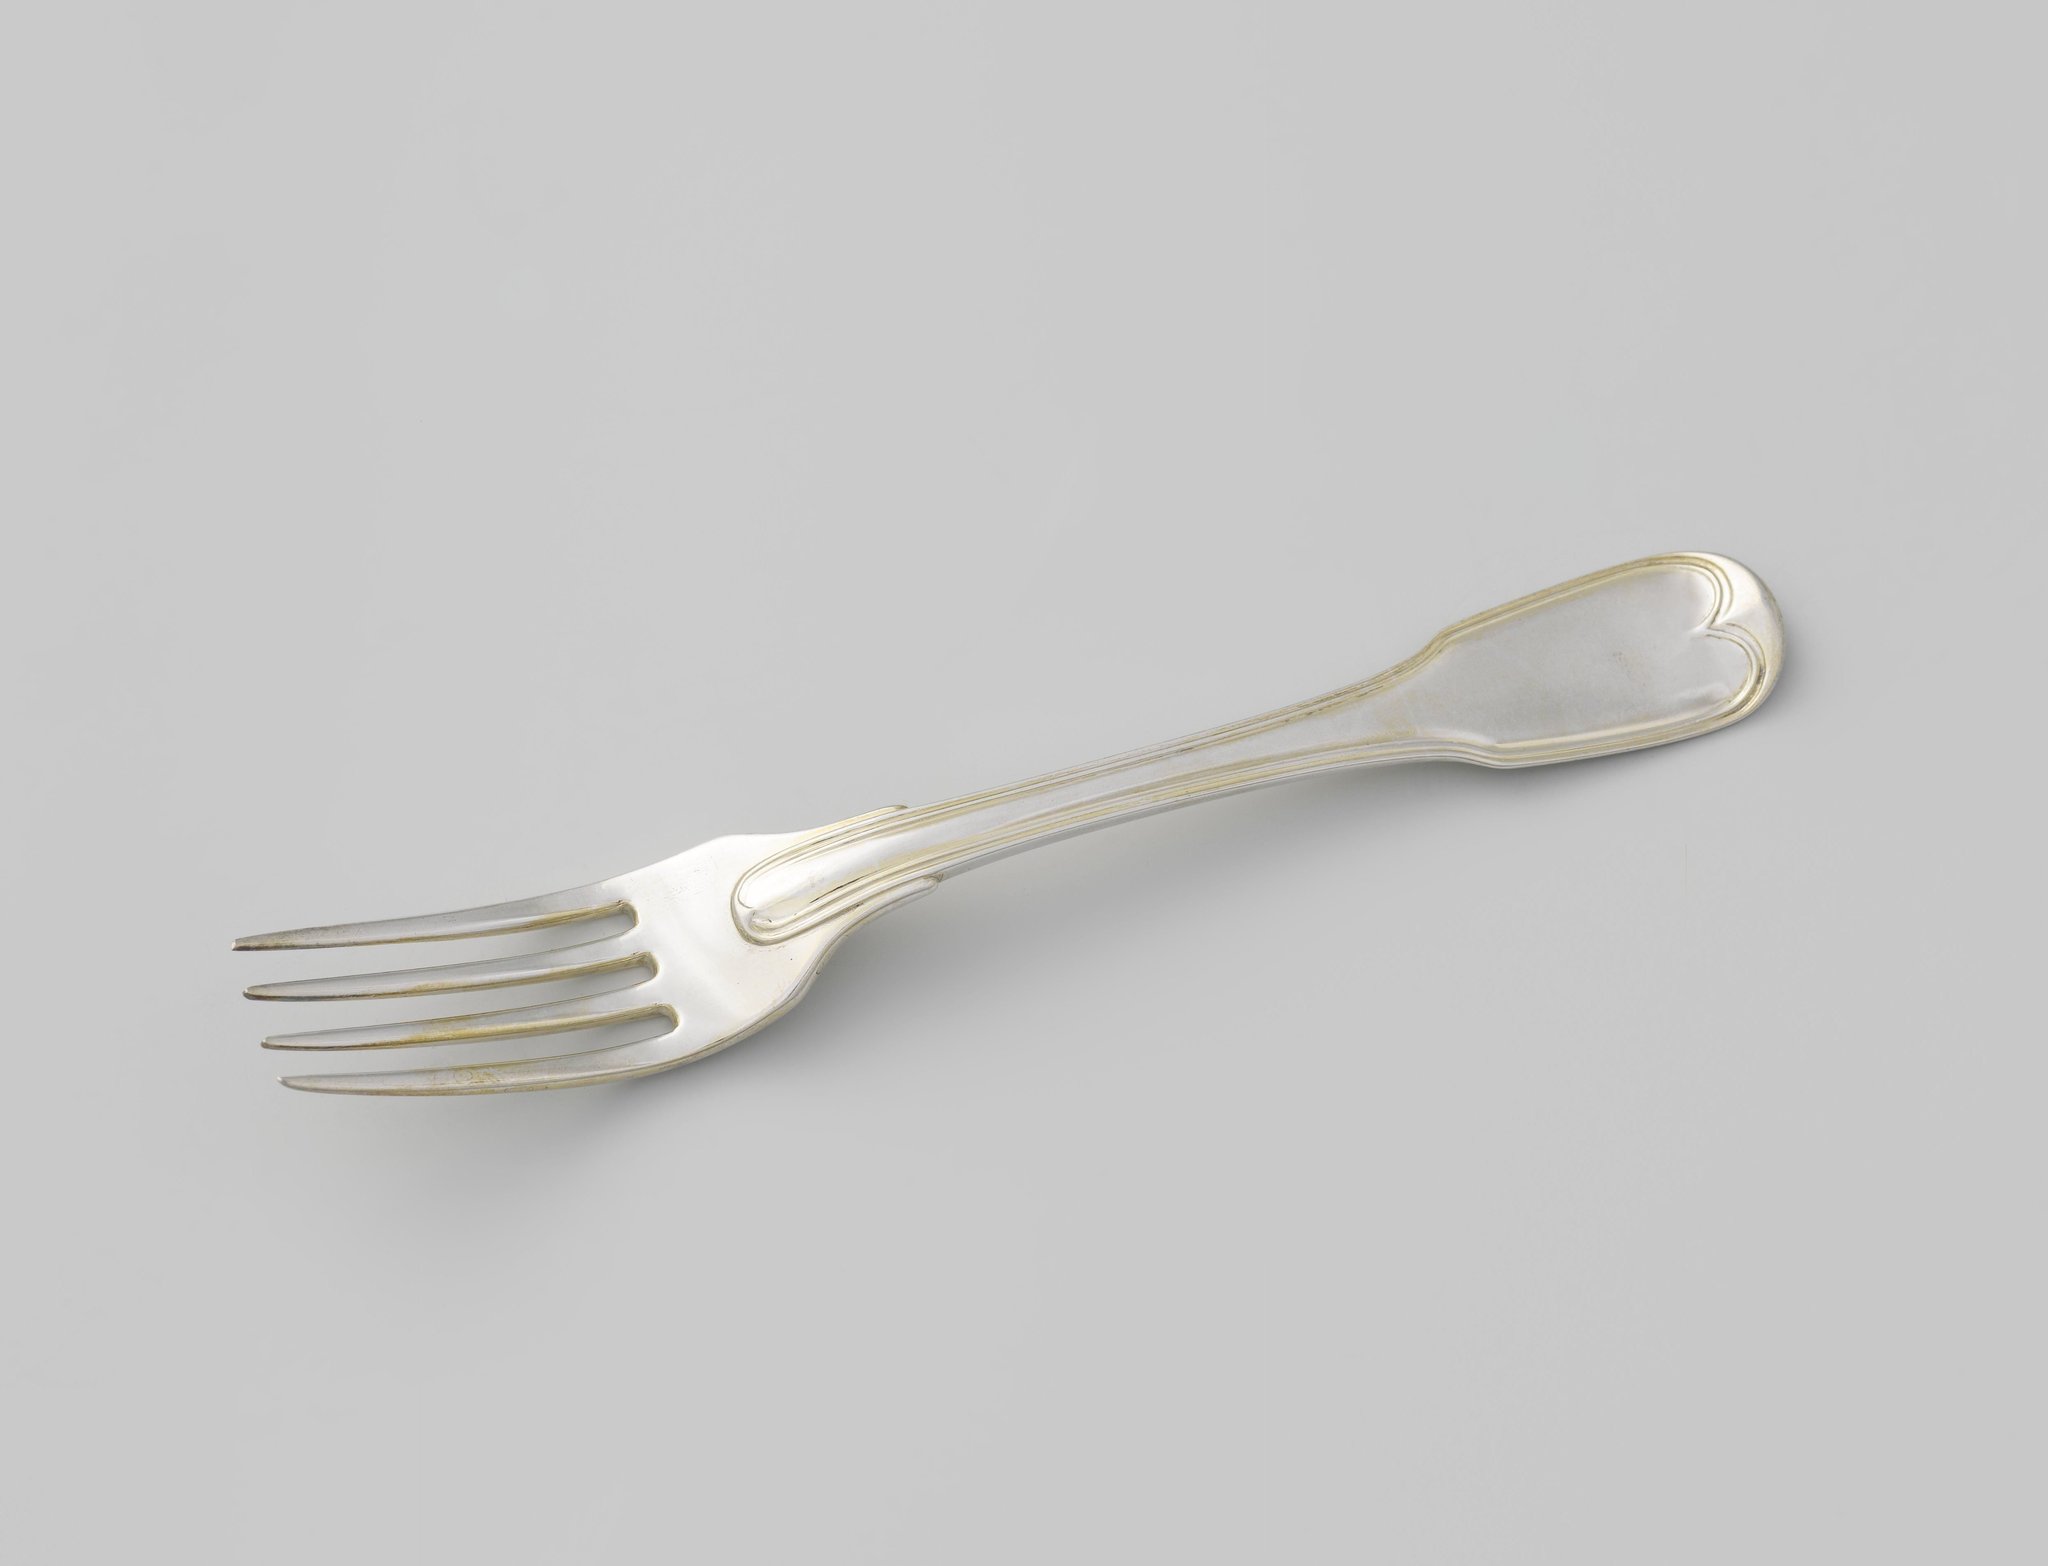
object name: fork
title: Vork met het helmteken Clifford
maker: hendrik helweg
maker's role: silversmith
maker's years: 1802-1858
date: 1832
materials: silver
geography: amsterdam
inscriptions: maker's mark: ‘HH onder anker in vierkant’, alloy mark: ‘leeuw 1ste gehalte’, hallmark: ‘Minervakop met A (keurkamer Amsterdam)’, date letter: ‘X (=1806)’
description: De viertandige vork is aan zowel boven- als onderzijde door middel van enkel lof verbonden met de platte, gebogen steel, die zich verbreedt naar het spatelvormige uiteinde. Boven- en onderzijde van de steel worden omgeven door een dubbele filetrand, die bij het uiteinde ingezwenkt is. Op de onderzijde van de spatel is het helmteken Clifford gegraveerd.